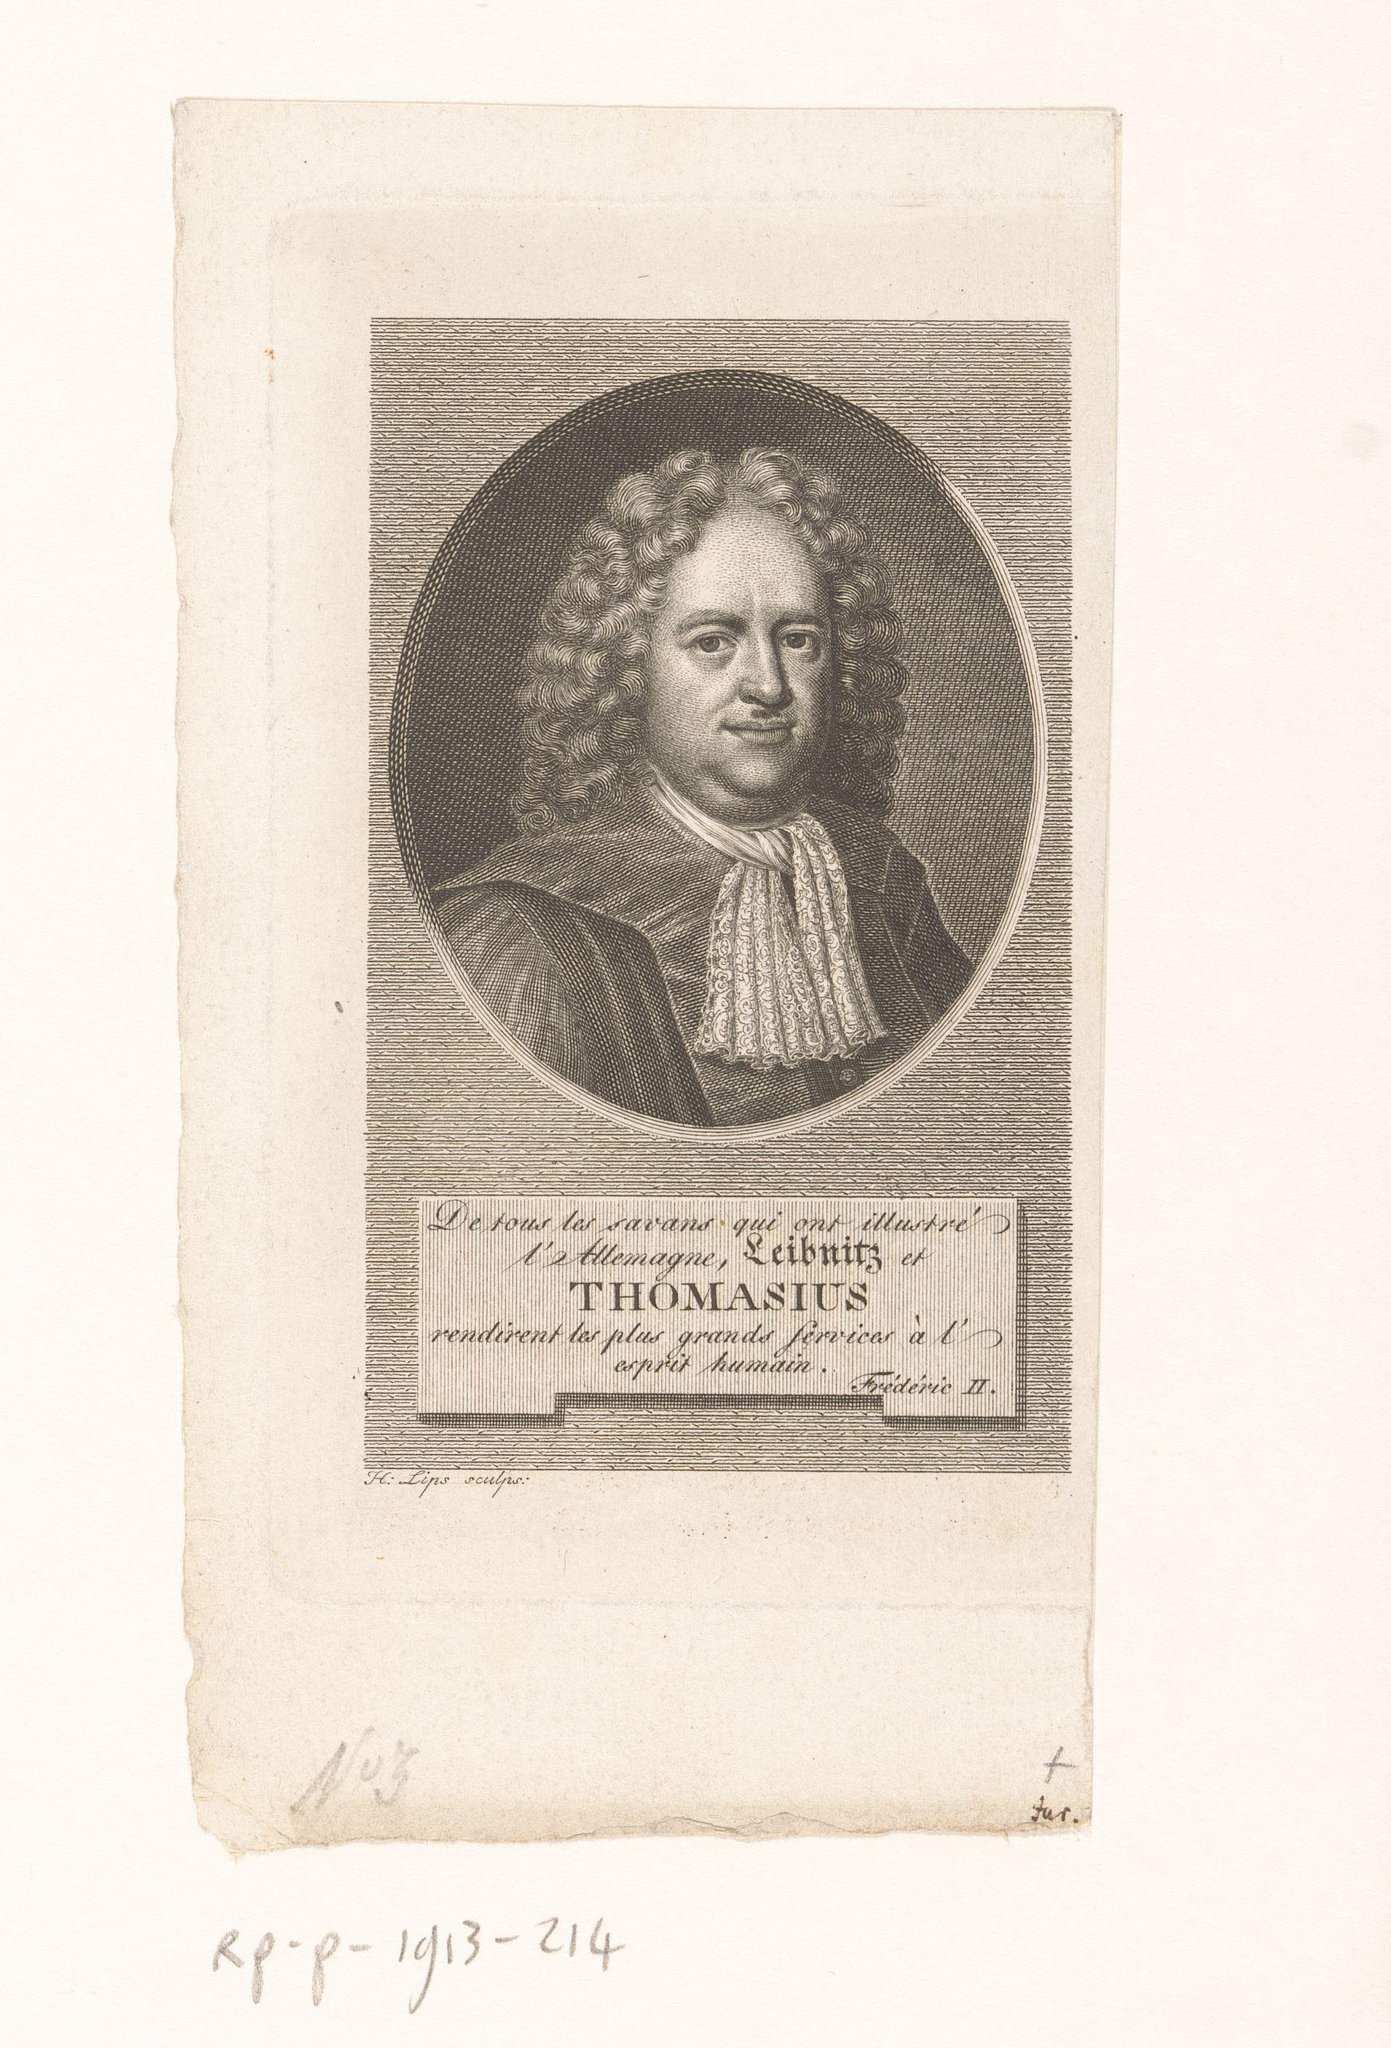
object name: print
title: Portret van Christian Thomasius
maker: johann heinrich lips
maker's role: draughtsman, painter, print maker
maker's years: 1758-1817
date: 1768-1817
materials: paper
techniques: engraving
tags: christian thomasius, historical persons, portrait of a writer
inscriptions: collector's mark: Lugt 2228